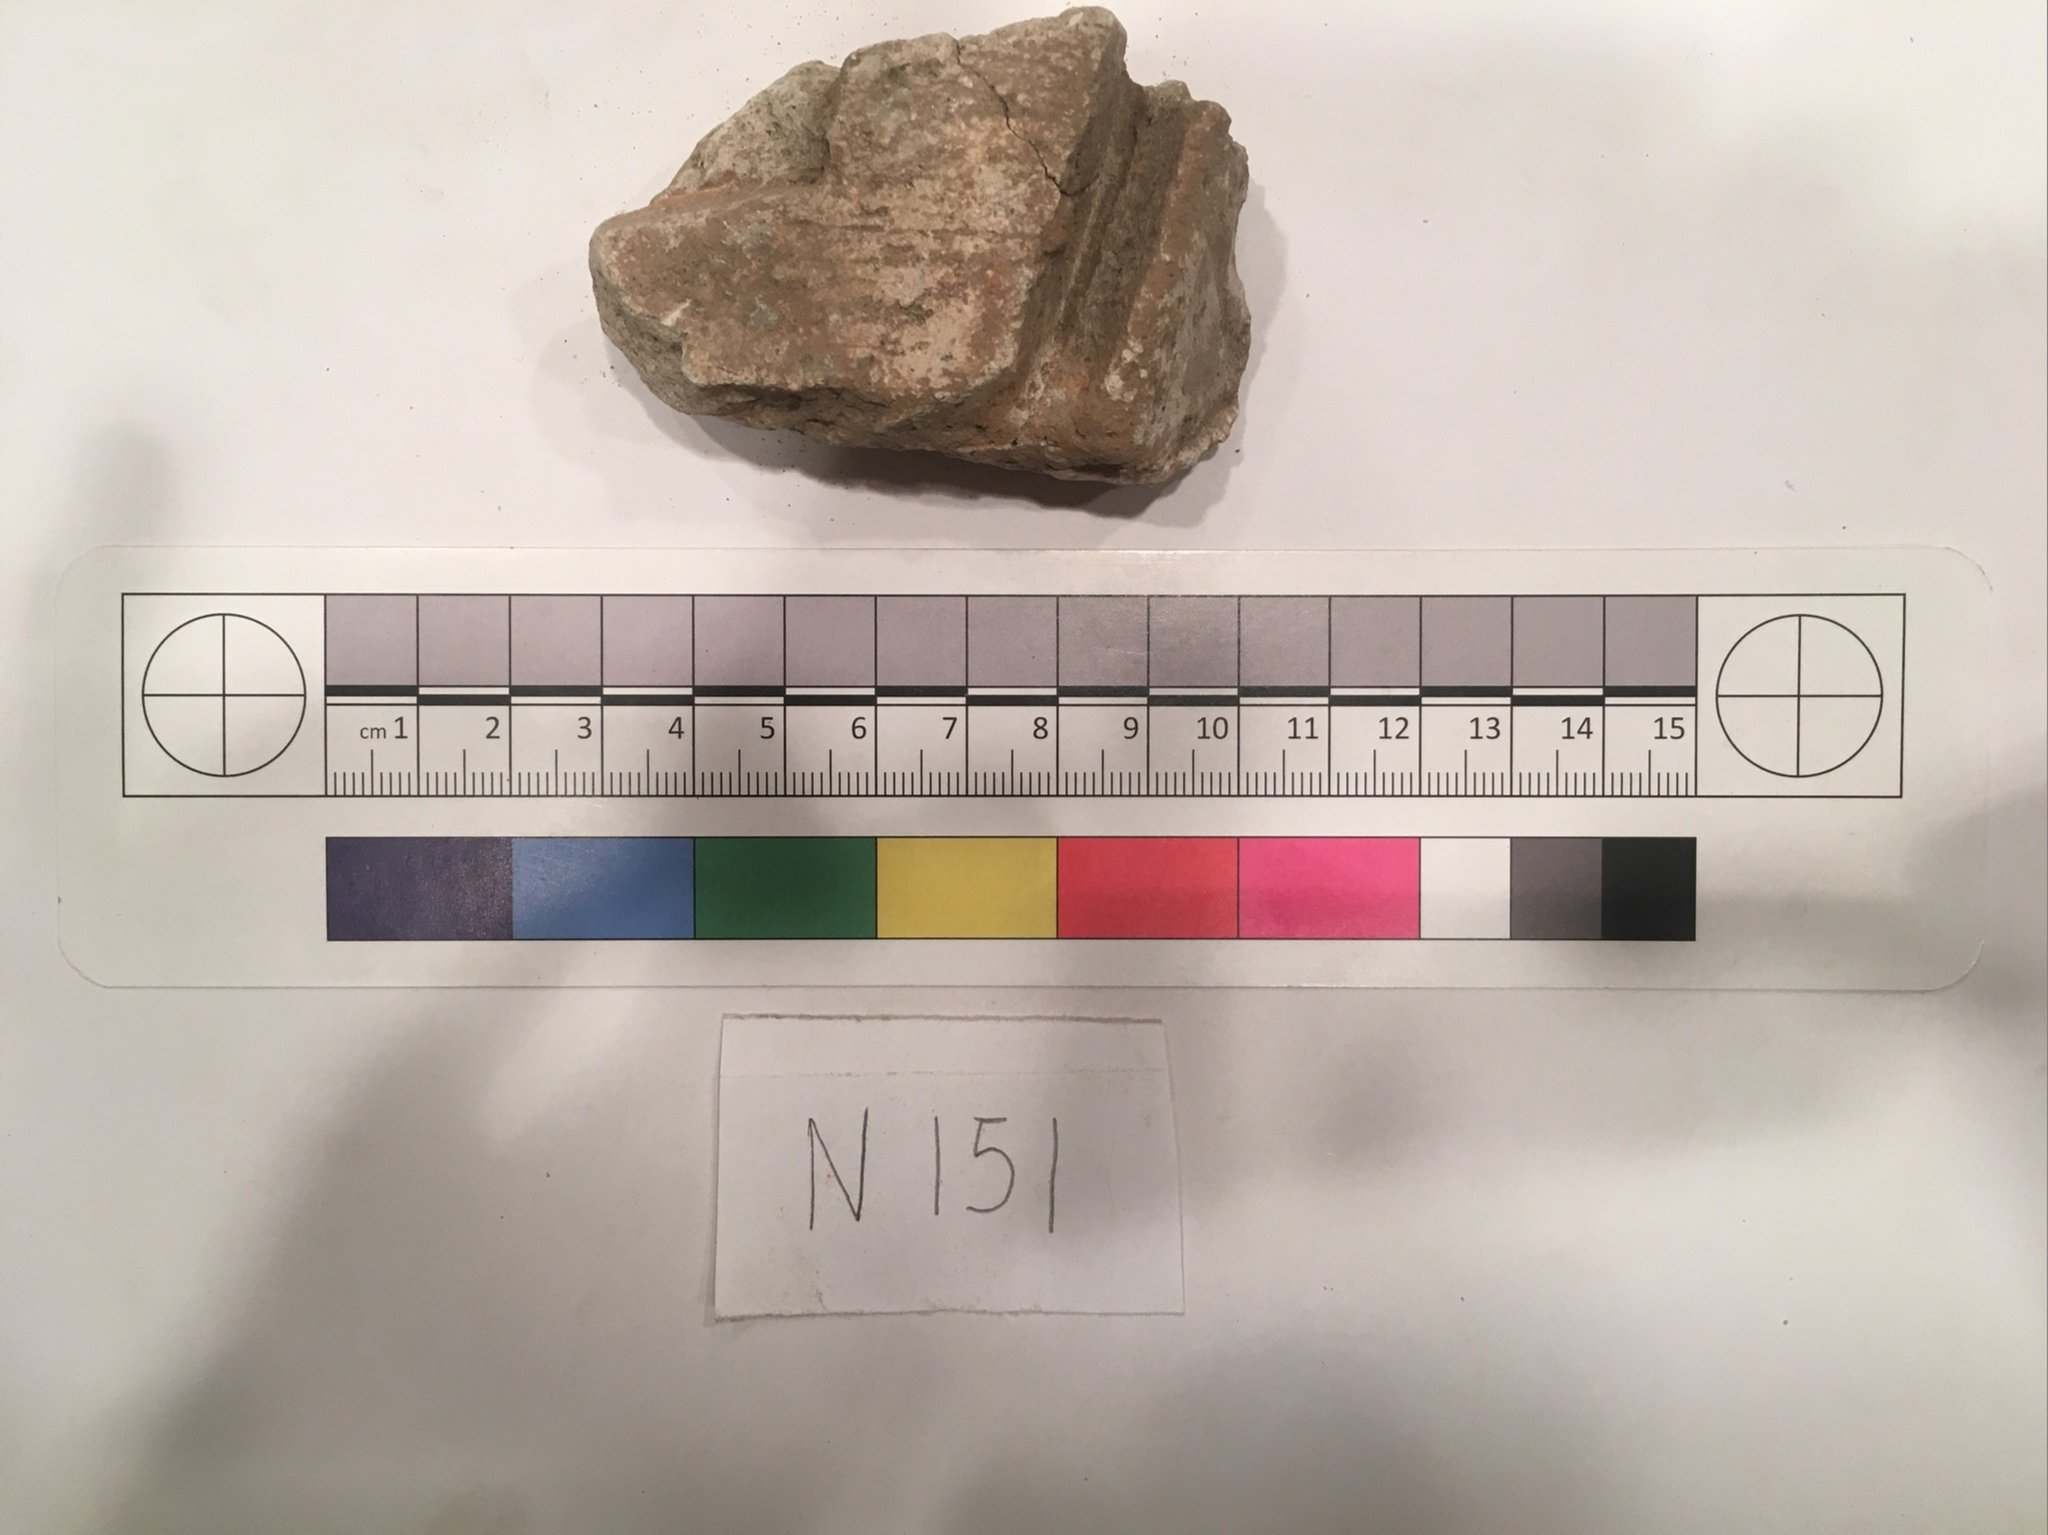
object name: fragment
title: Stucco Fragment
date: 701-1200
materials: plaster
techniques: carving, painting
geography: iran